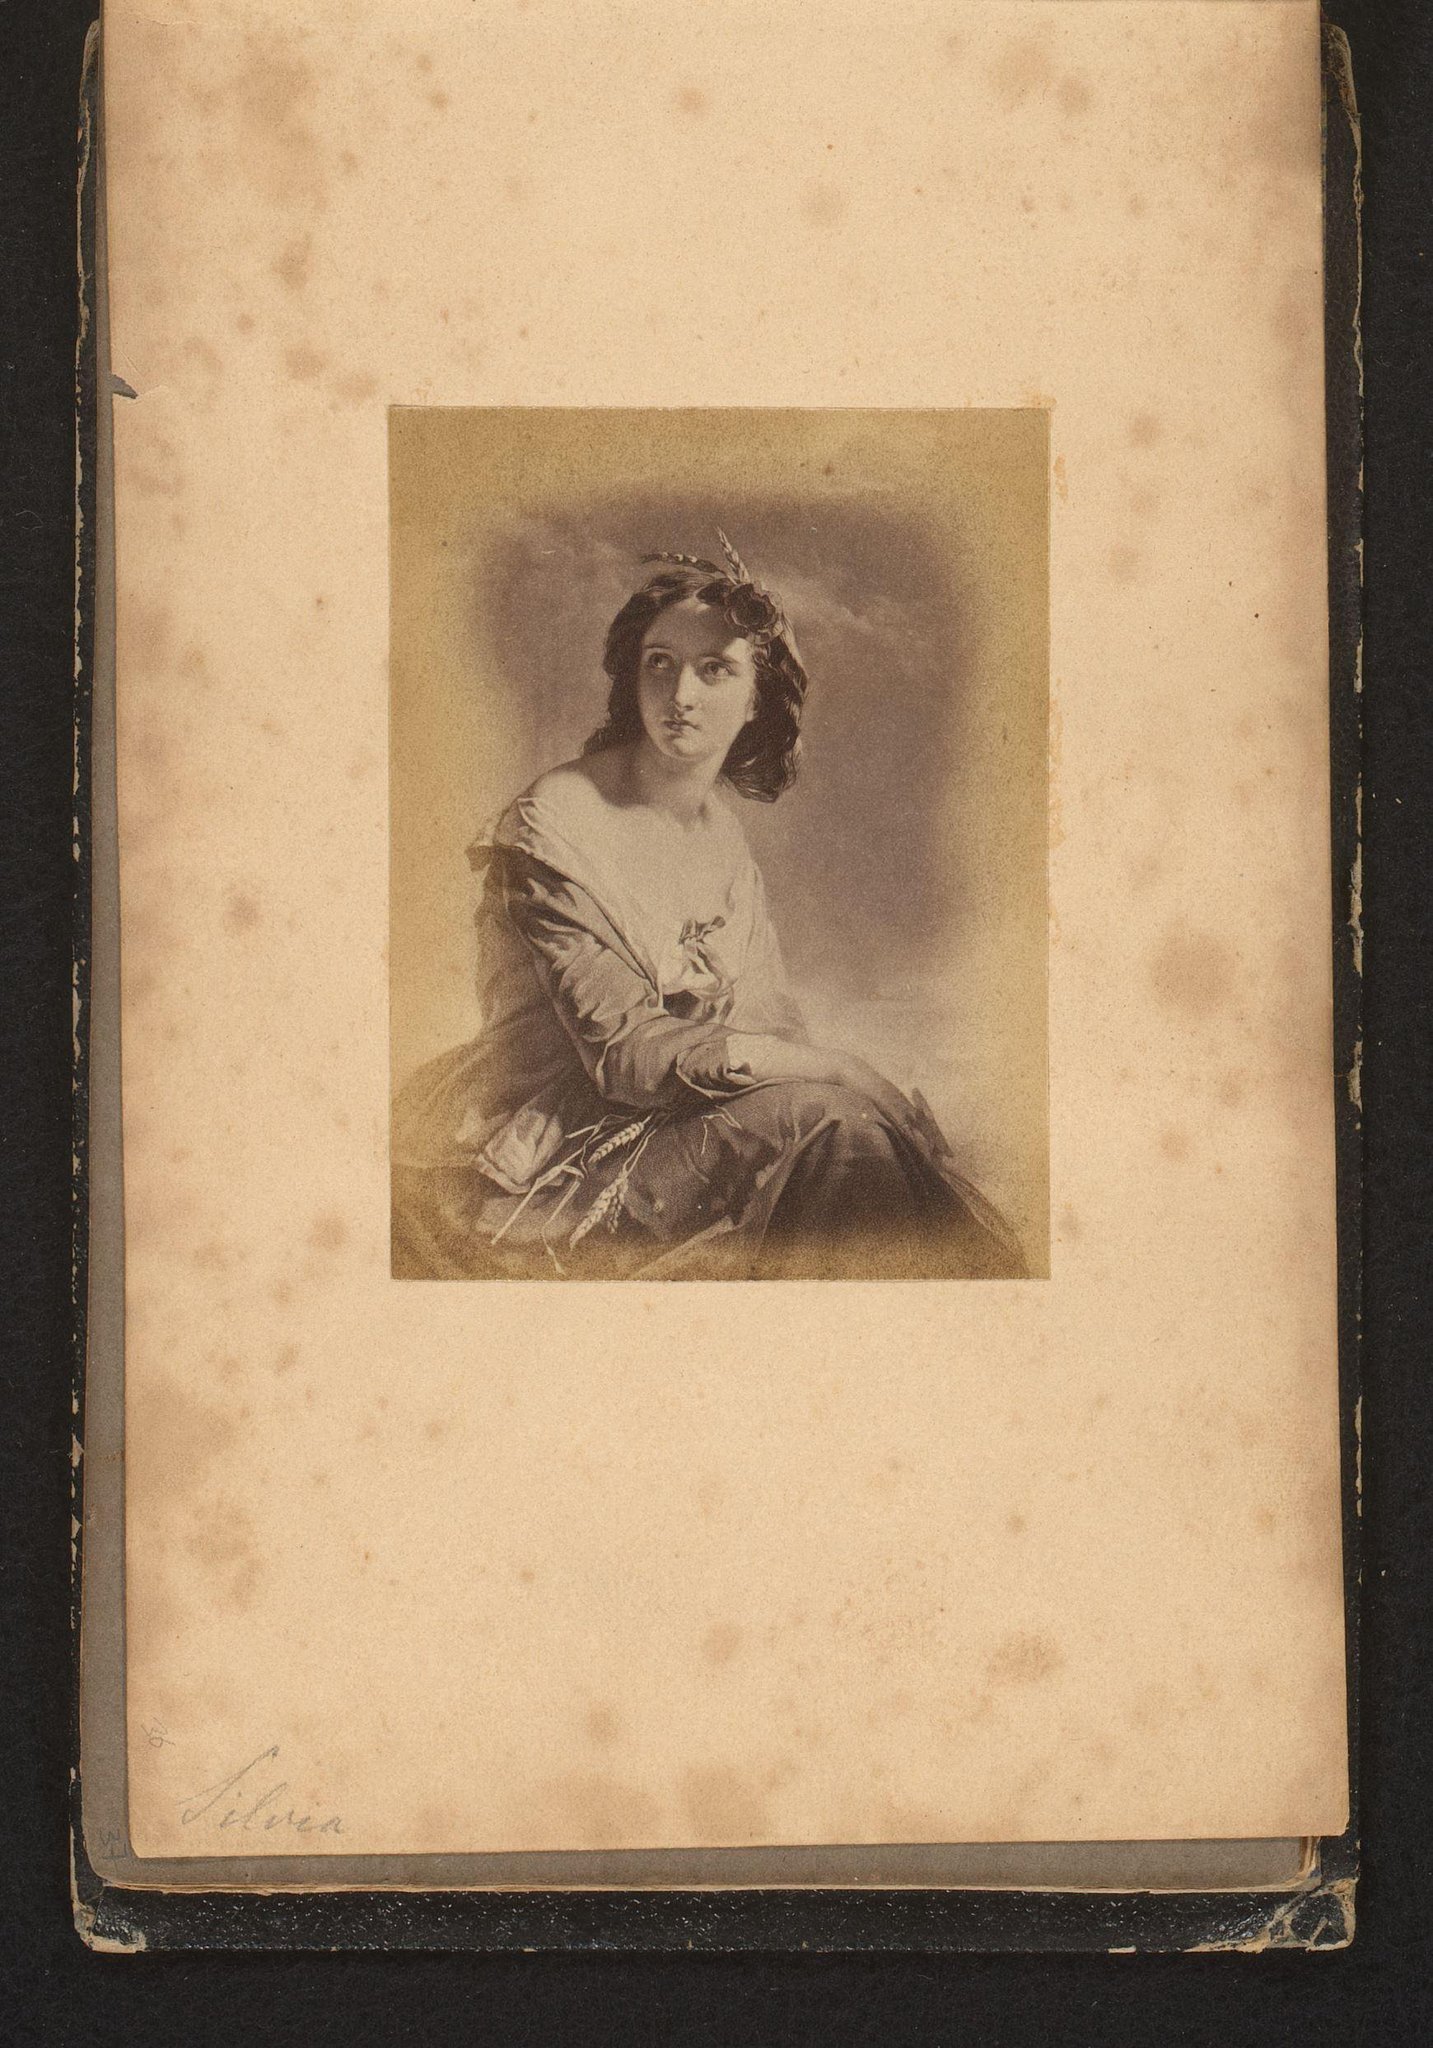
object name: photograph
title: Fotoreproductie van een geschilderd portret van een zittende vrouw met een bloem in het haar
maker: Anonymous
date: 1860-1900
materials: photographic support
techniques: albumen print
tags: flowers, sitting figure - aa - female human figure, painting, drawing and the graphic arts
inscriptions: annotation: ‘Silvia’